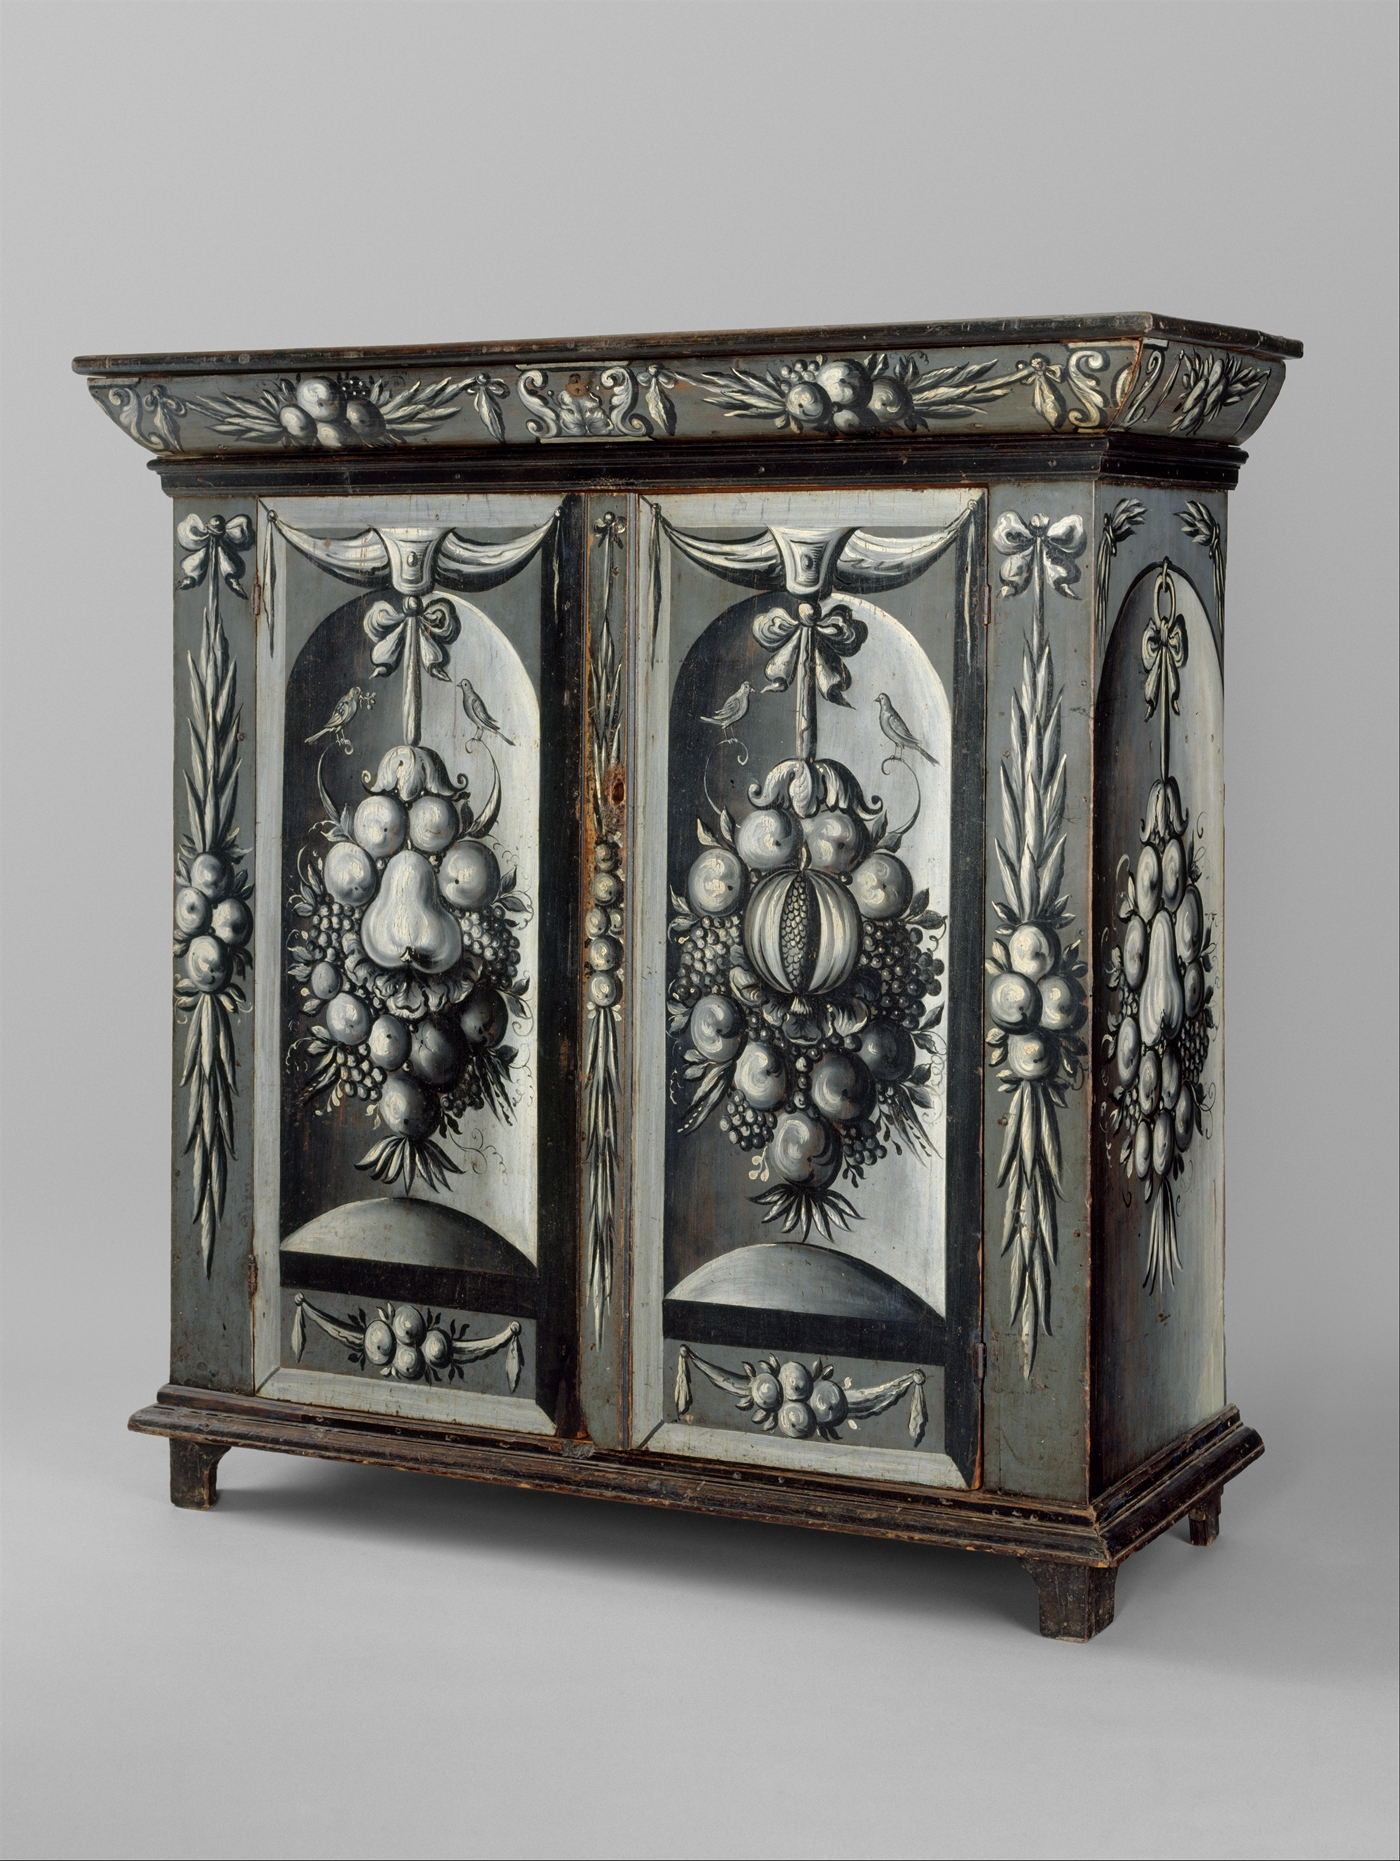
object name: kast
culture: american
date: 1690-1720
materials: wood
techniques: painting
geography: united states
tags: fruit